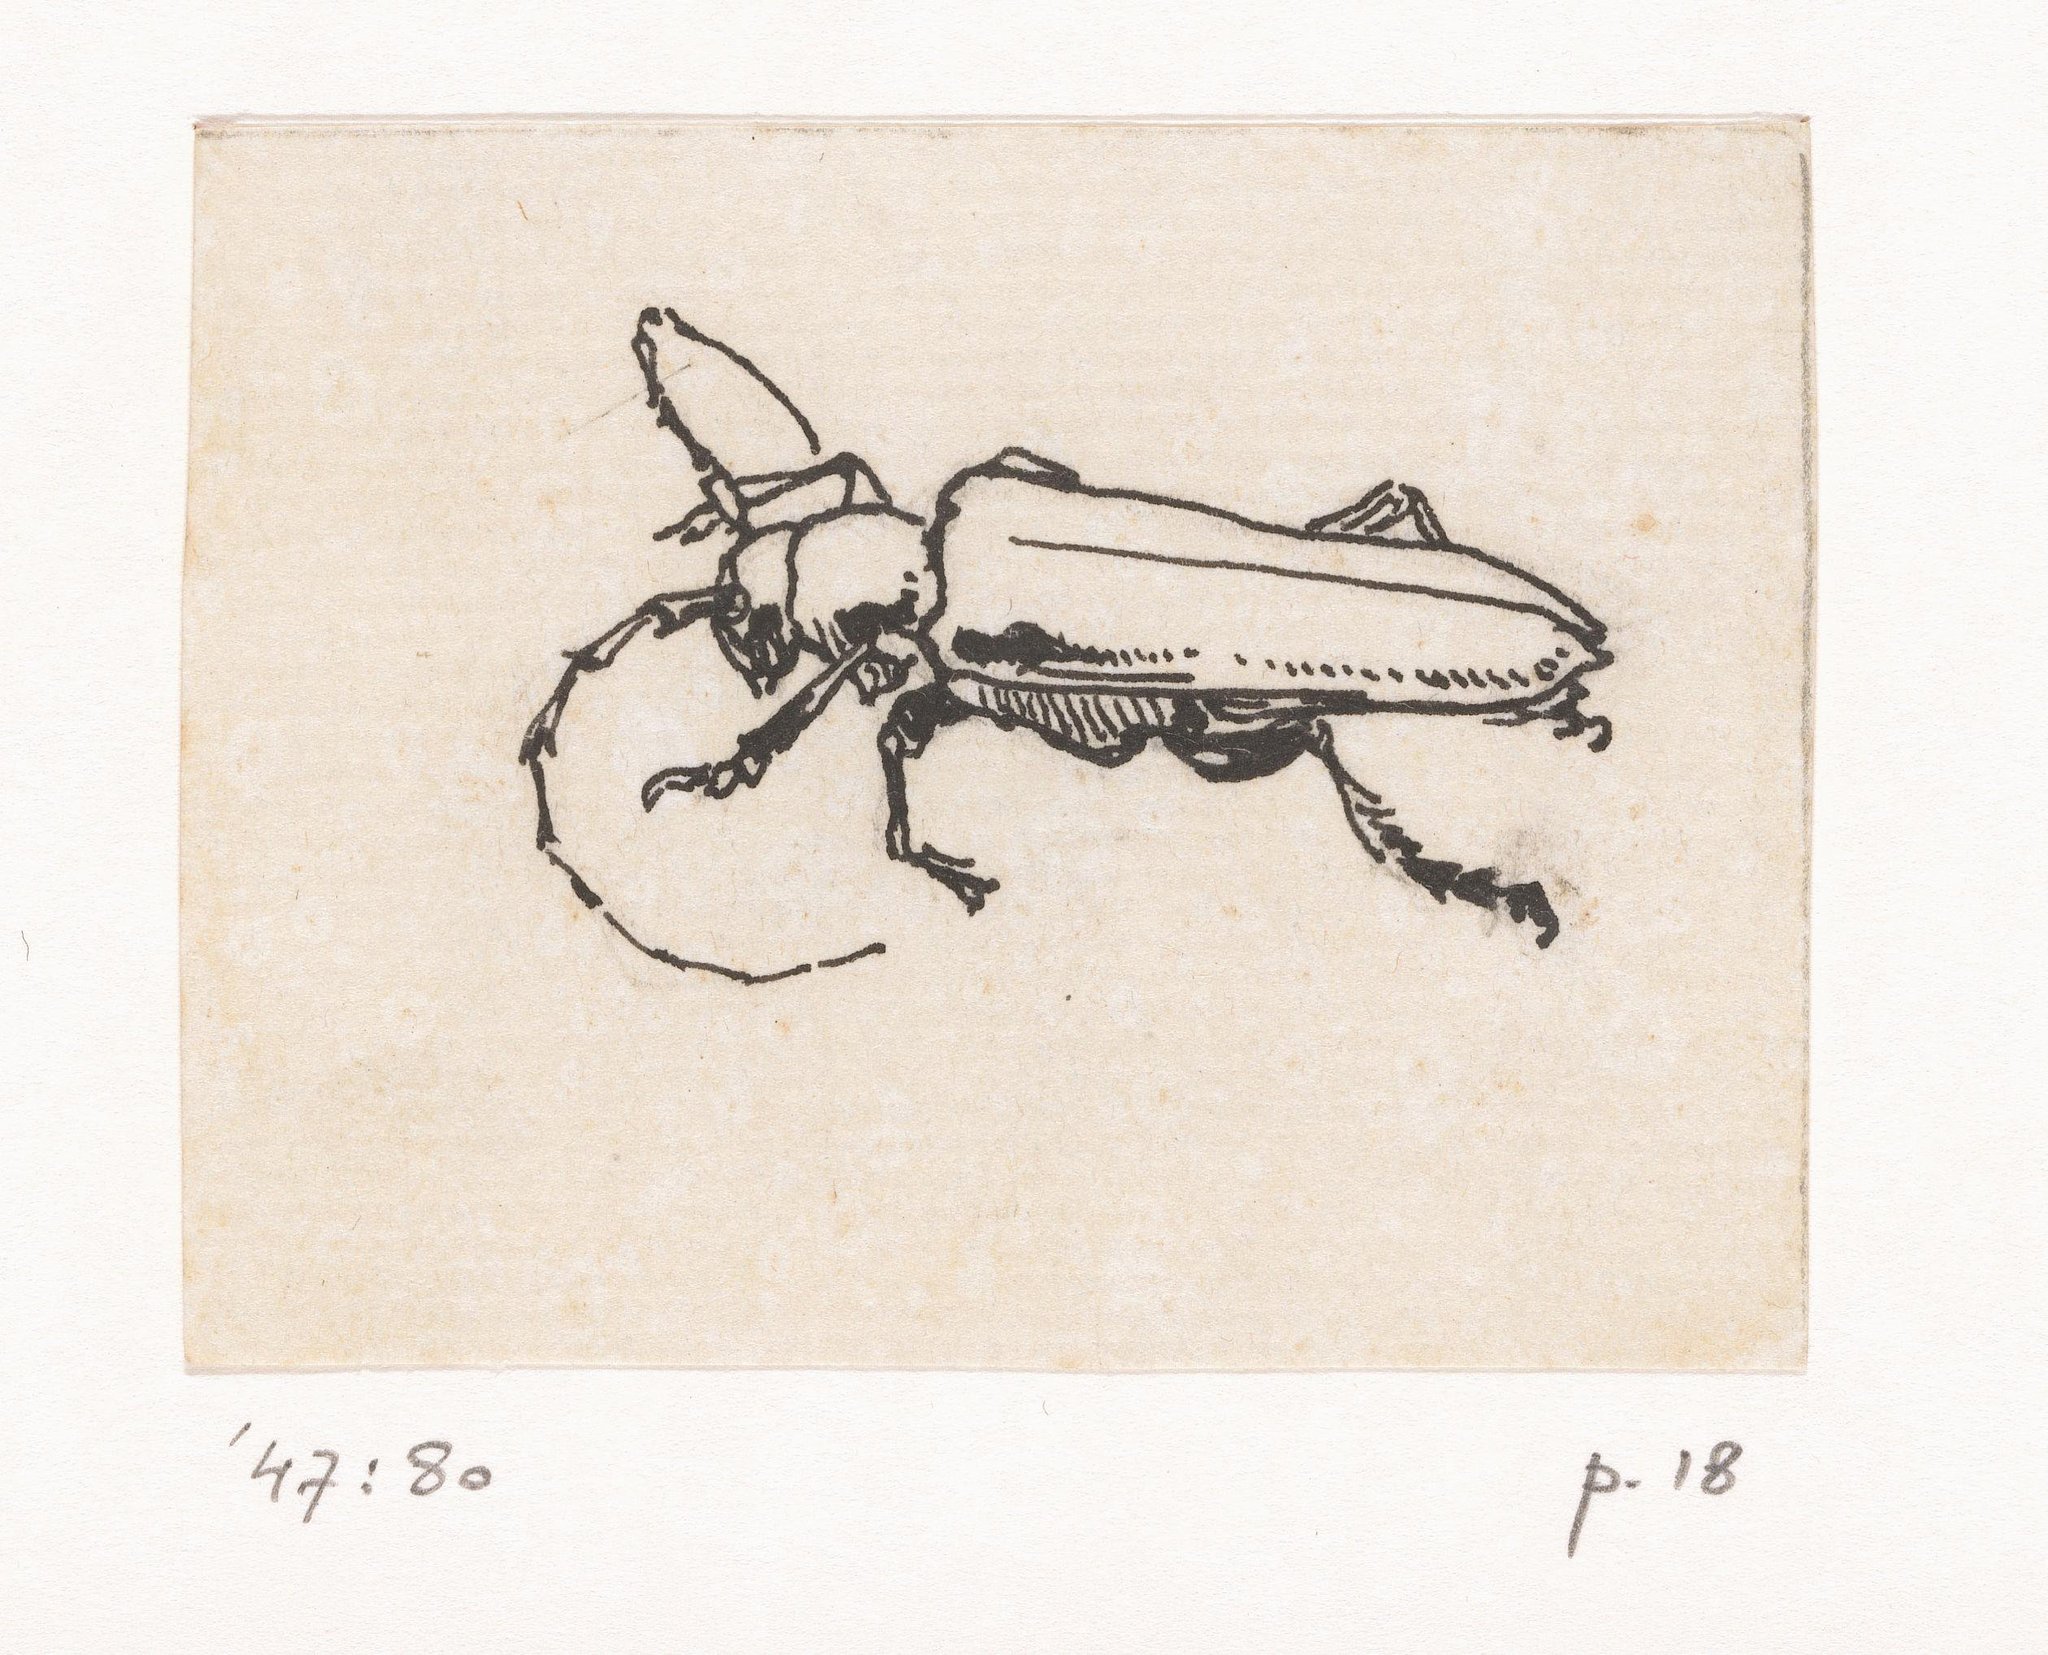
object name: boekillustratie ontwerp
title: Kever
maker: willem wenckebach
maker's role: designer, draughtsman, painter, print maker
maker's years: 1860-1937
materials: ink, paper, pencil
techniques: pen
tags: insects: beetle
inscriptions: collector's mark: Lugt 2228a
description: Ontwerp voor: Knappert, Emilie C. Kijkjes in de plantenwereld. Loman & Funke: Amsterdam, 1893.